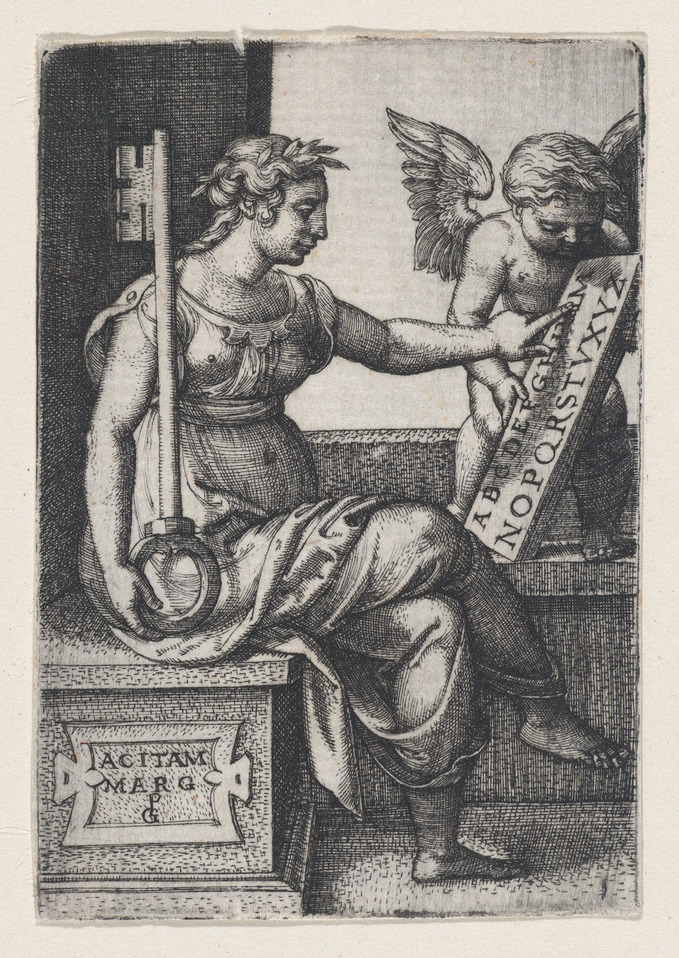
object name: print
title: Grammatica, from "The Liberal Arts"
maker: georg pencz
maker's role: artist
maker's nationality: german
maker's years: 1500-1550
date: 1536-1546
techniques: engraving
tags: women,keys